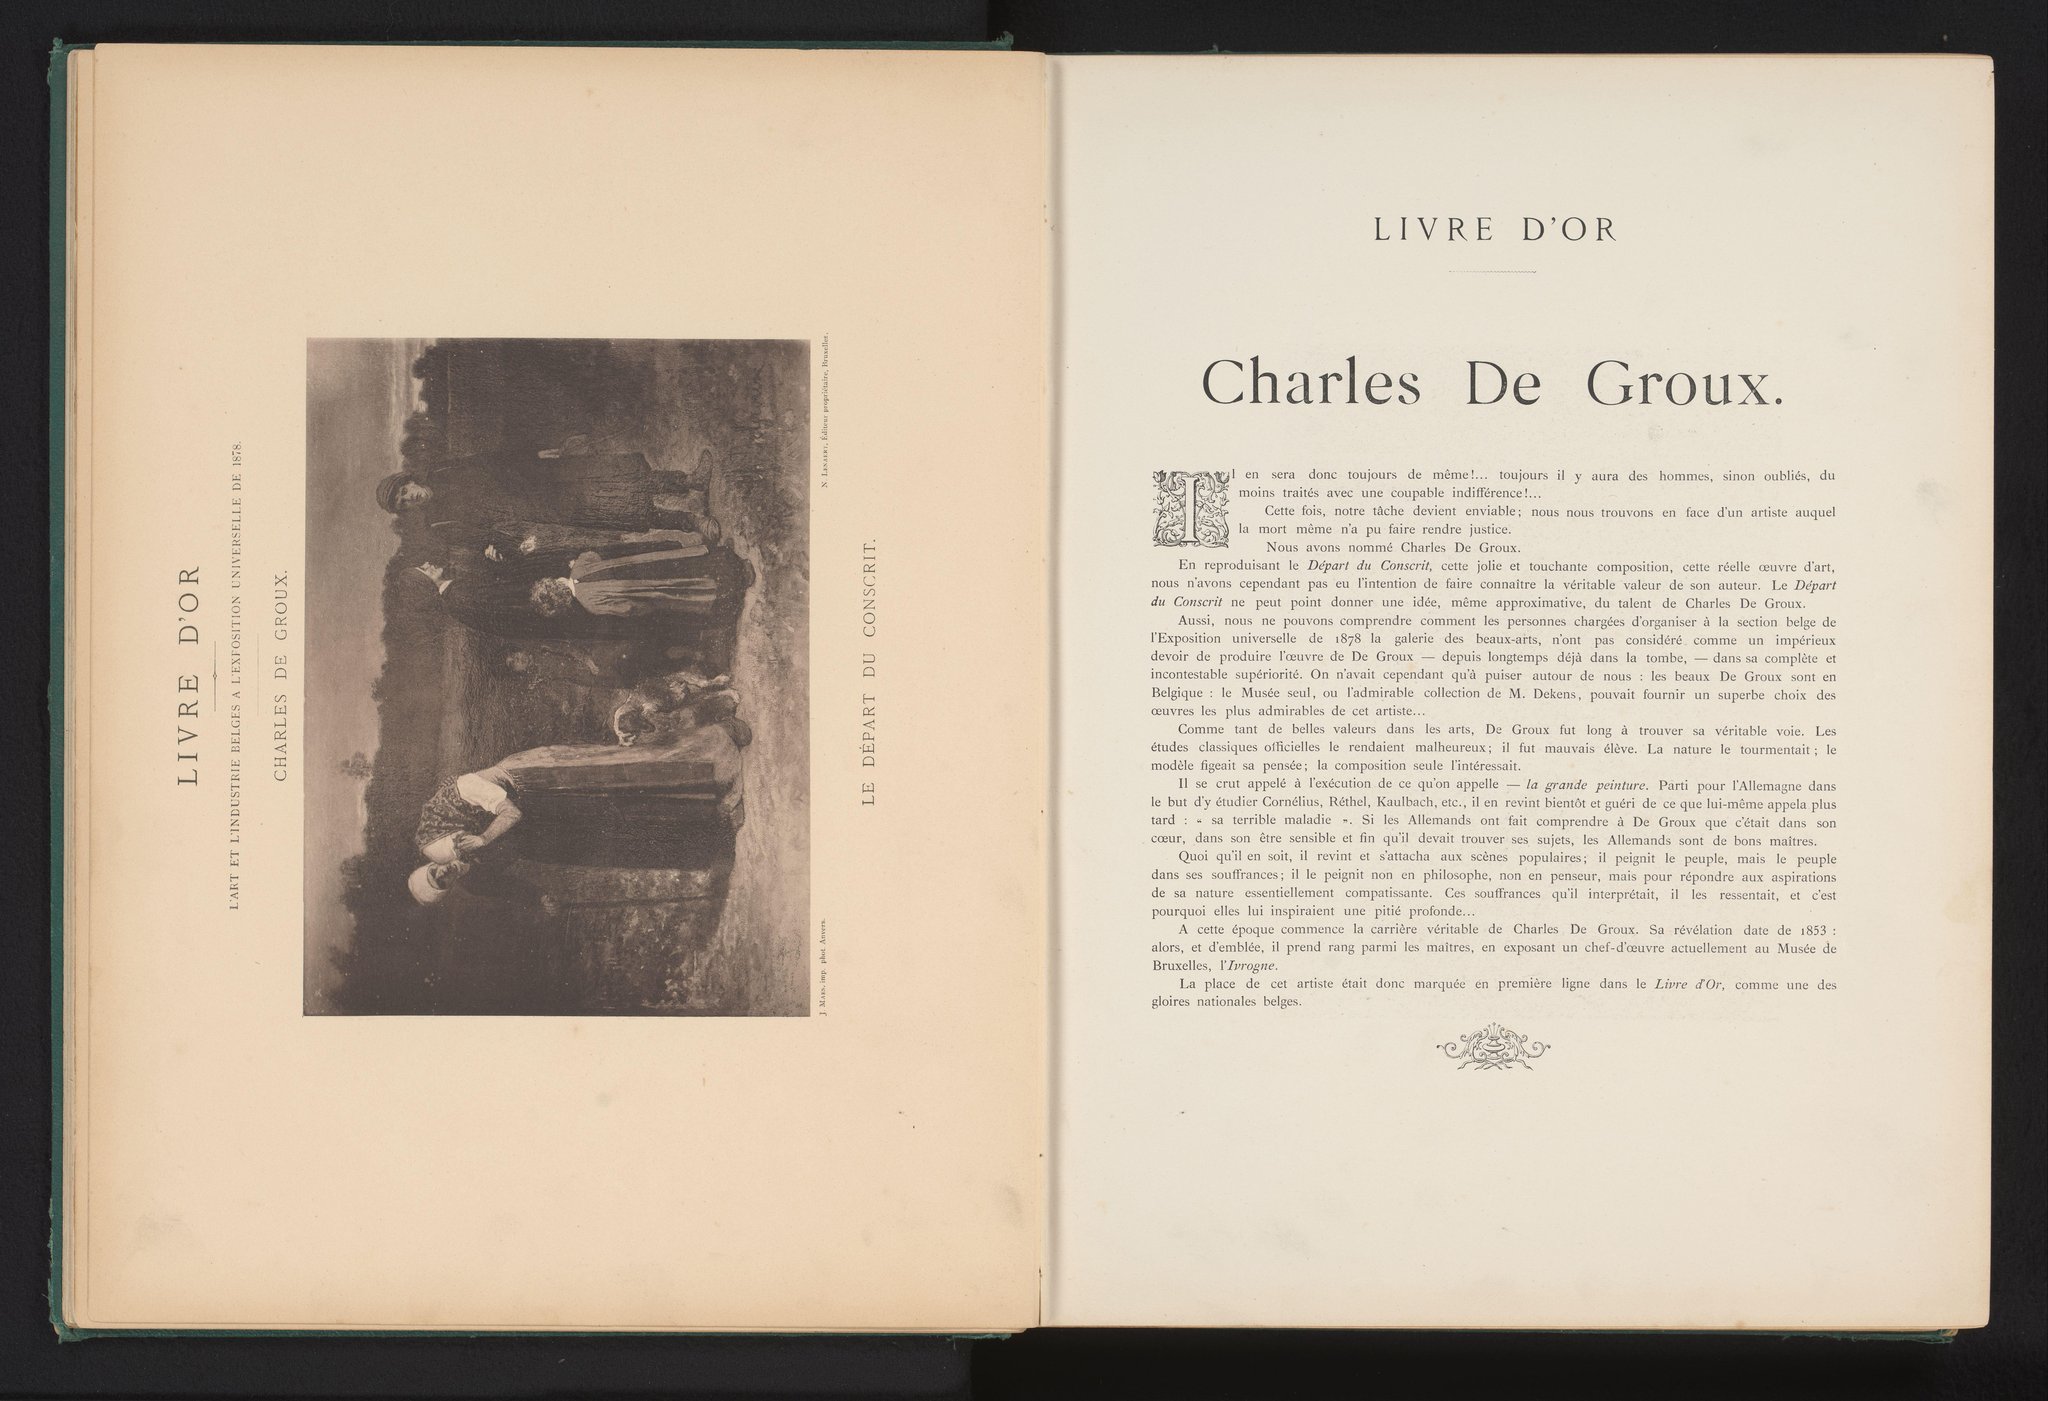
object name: photomechanical print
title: Reproductie van een schilderij van het afscheid van een dienstplichtige jongen door Charles de Groux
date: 1874-1879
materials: paper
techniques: photograph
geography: brussels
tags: conscription ~ enlisting, waving farewell ~ departure on a journey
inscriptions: inscription: ‘Livre d'or/ L'art et l'industrie Belges a l'exposition universelle de 1878.’